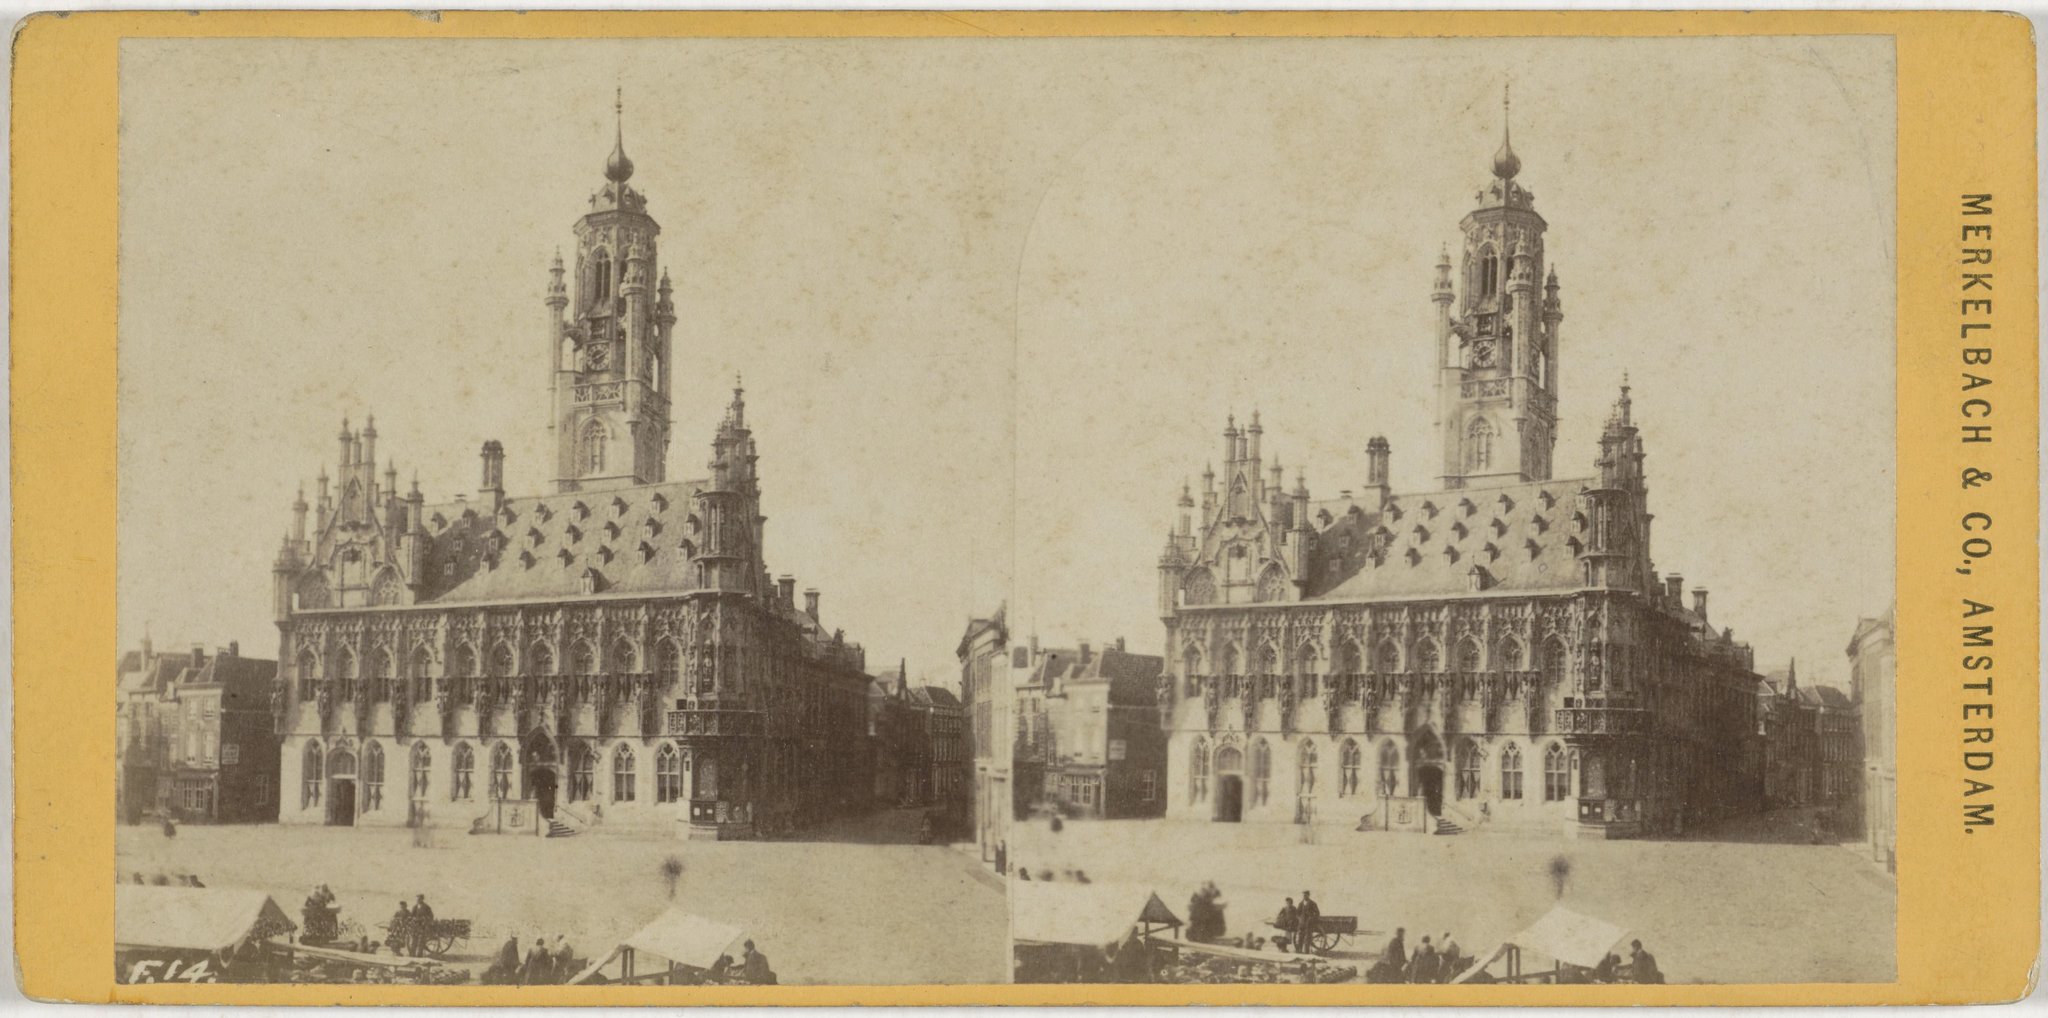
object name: stereograph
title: Aardrijkskundige beeldengalerij, verzameld door M.J. Broekhuijsen, hoofd eener school te Amsterdam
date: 1900-1902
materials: cardboard, paper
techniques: albumen print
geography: amsterdam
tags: square, place, circus, etc., townhall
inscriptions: number: ‘14.’, number: ‘F.14.’